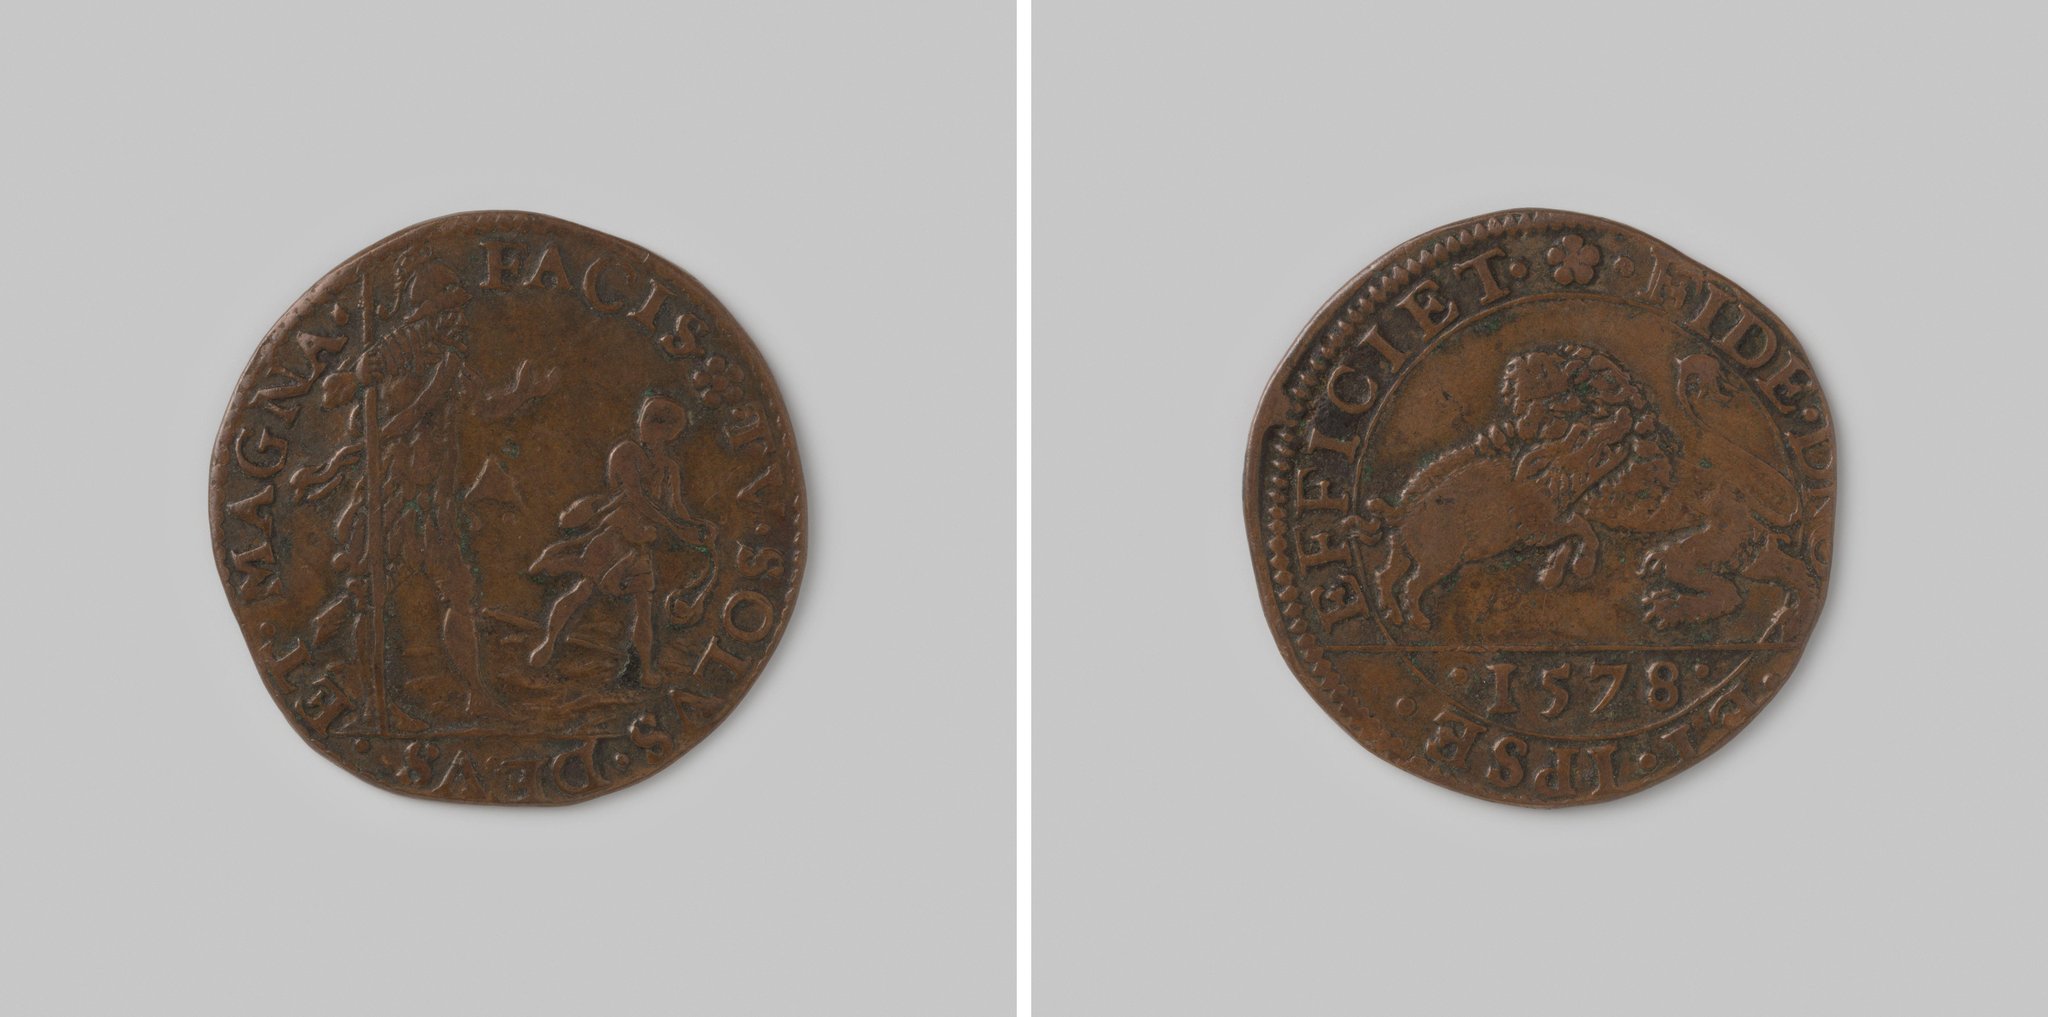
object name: history medal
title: Rekenpenning uit Dordrecht op de strijd tegen Spanje 1578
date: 1578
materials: copper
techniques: striking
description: Koperen penning, op de voorzijde Goliath en David met slinger, met omschrift, op de keerzijde een leeuw die een zwijn aanvalt, met afsnedetekst en omschrift.